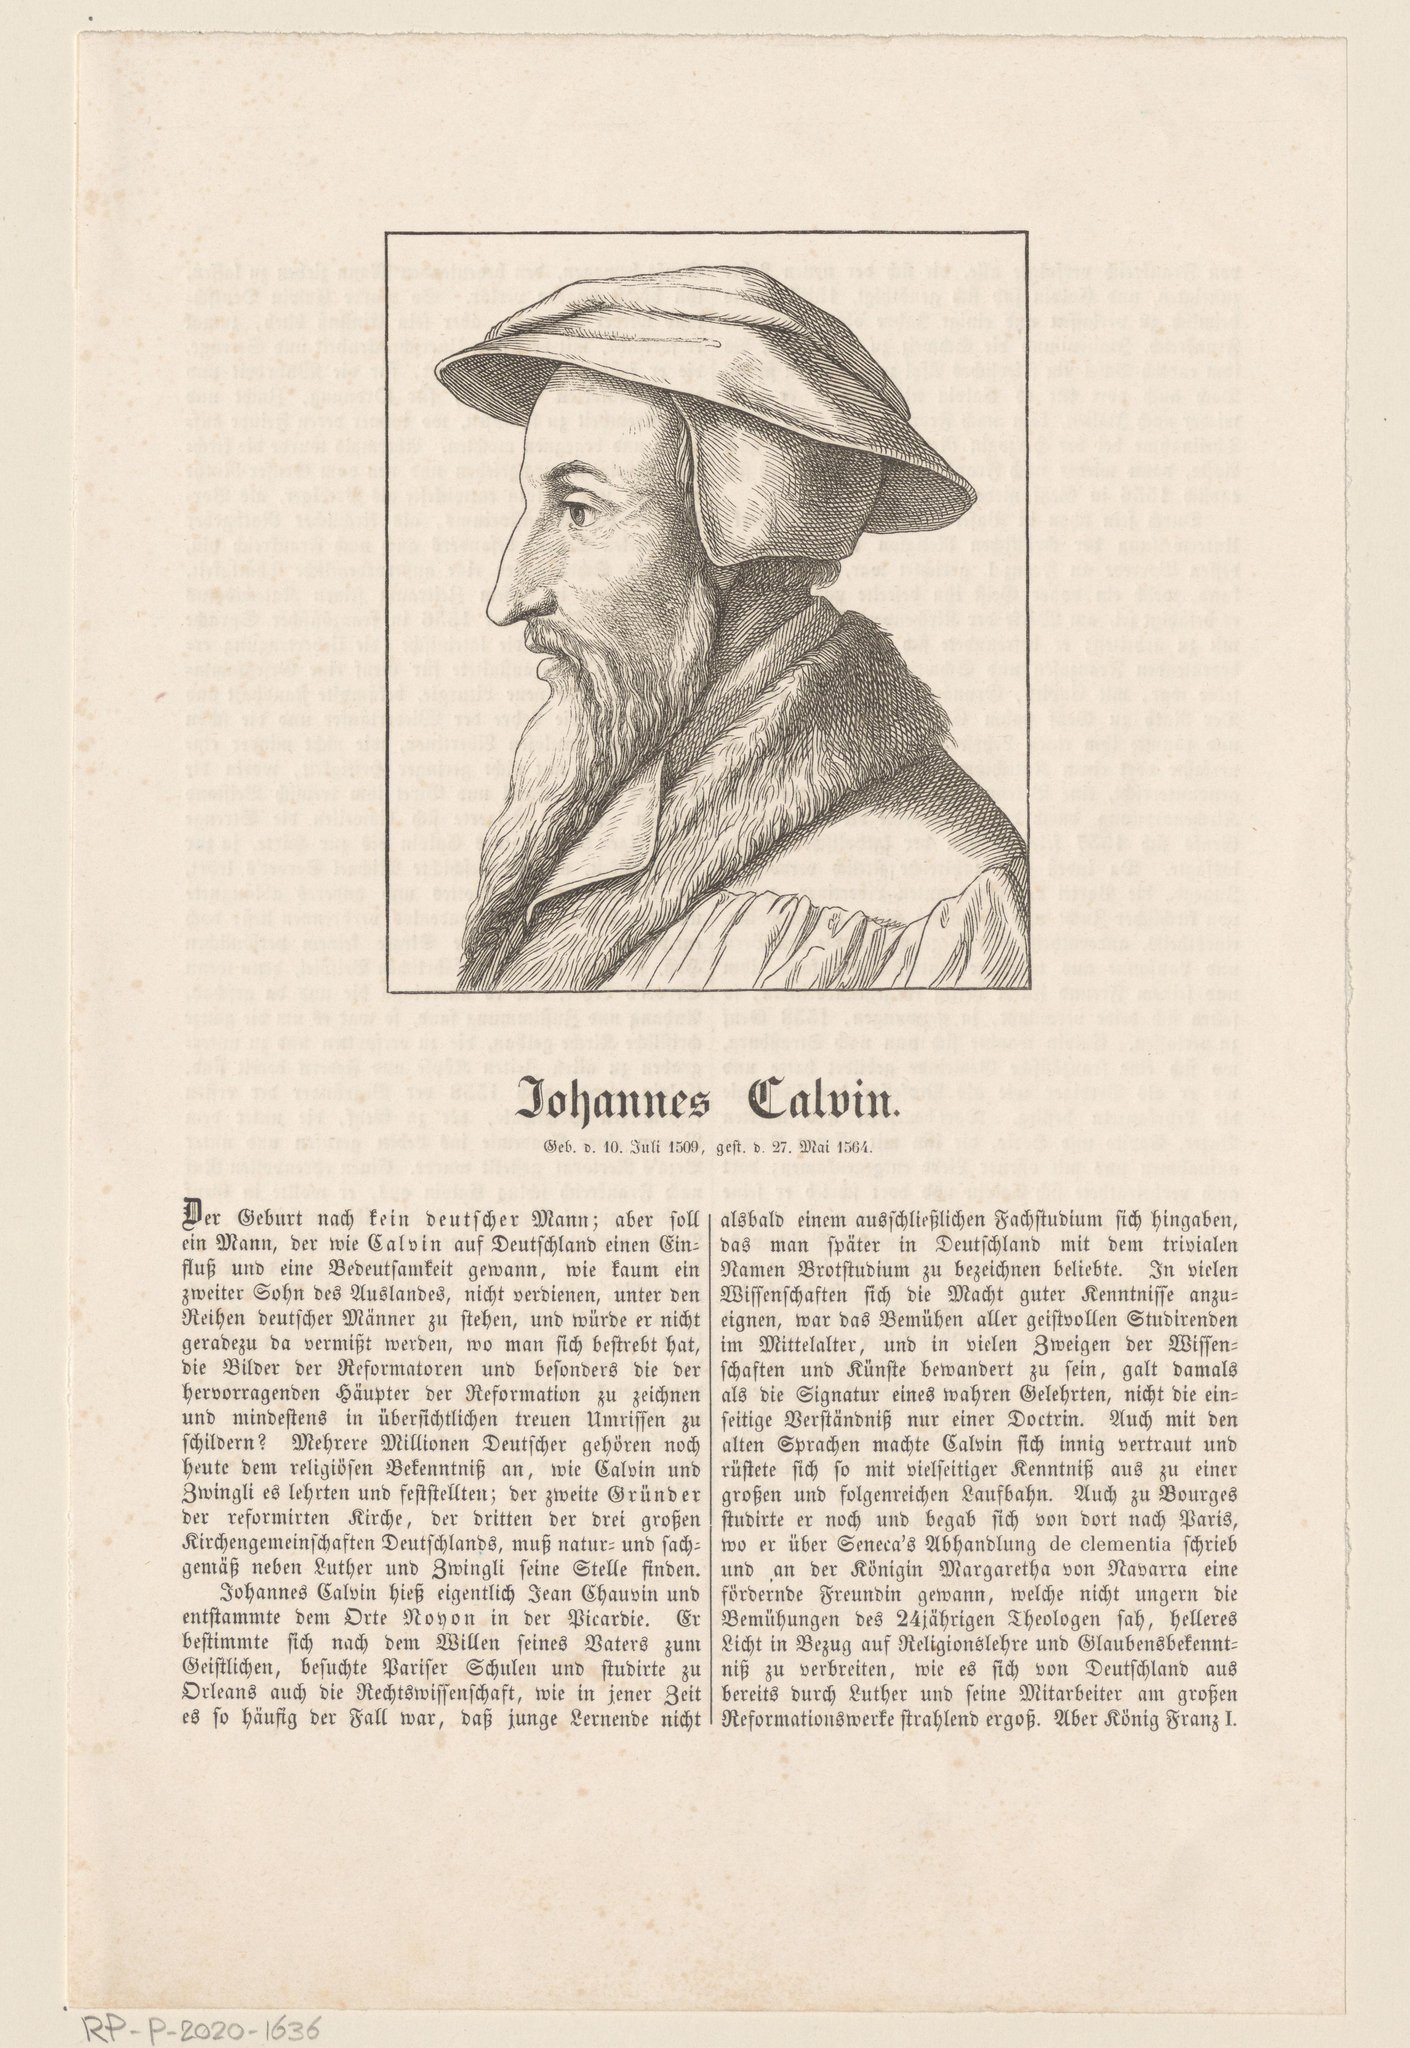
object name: photomechanical print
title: Portret van Johannes Calvijn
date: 1854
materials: paper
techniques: letterpress printing, printing block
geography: leipzig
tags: historical persons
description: Prent uit: Bechstein, Ludwig. Zweihundert deutsche Männer in Bildnissen und Lebensbeschreibungen. Leipzig: Balthasar Wigand, 1854.